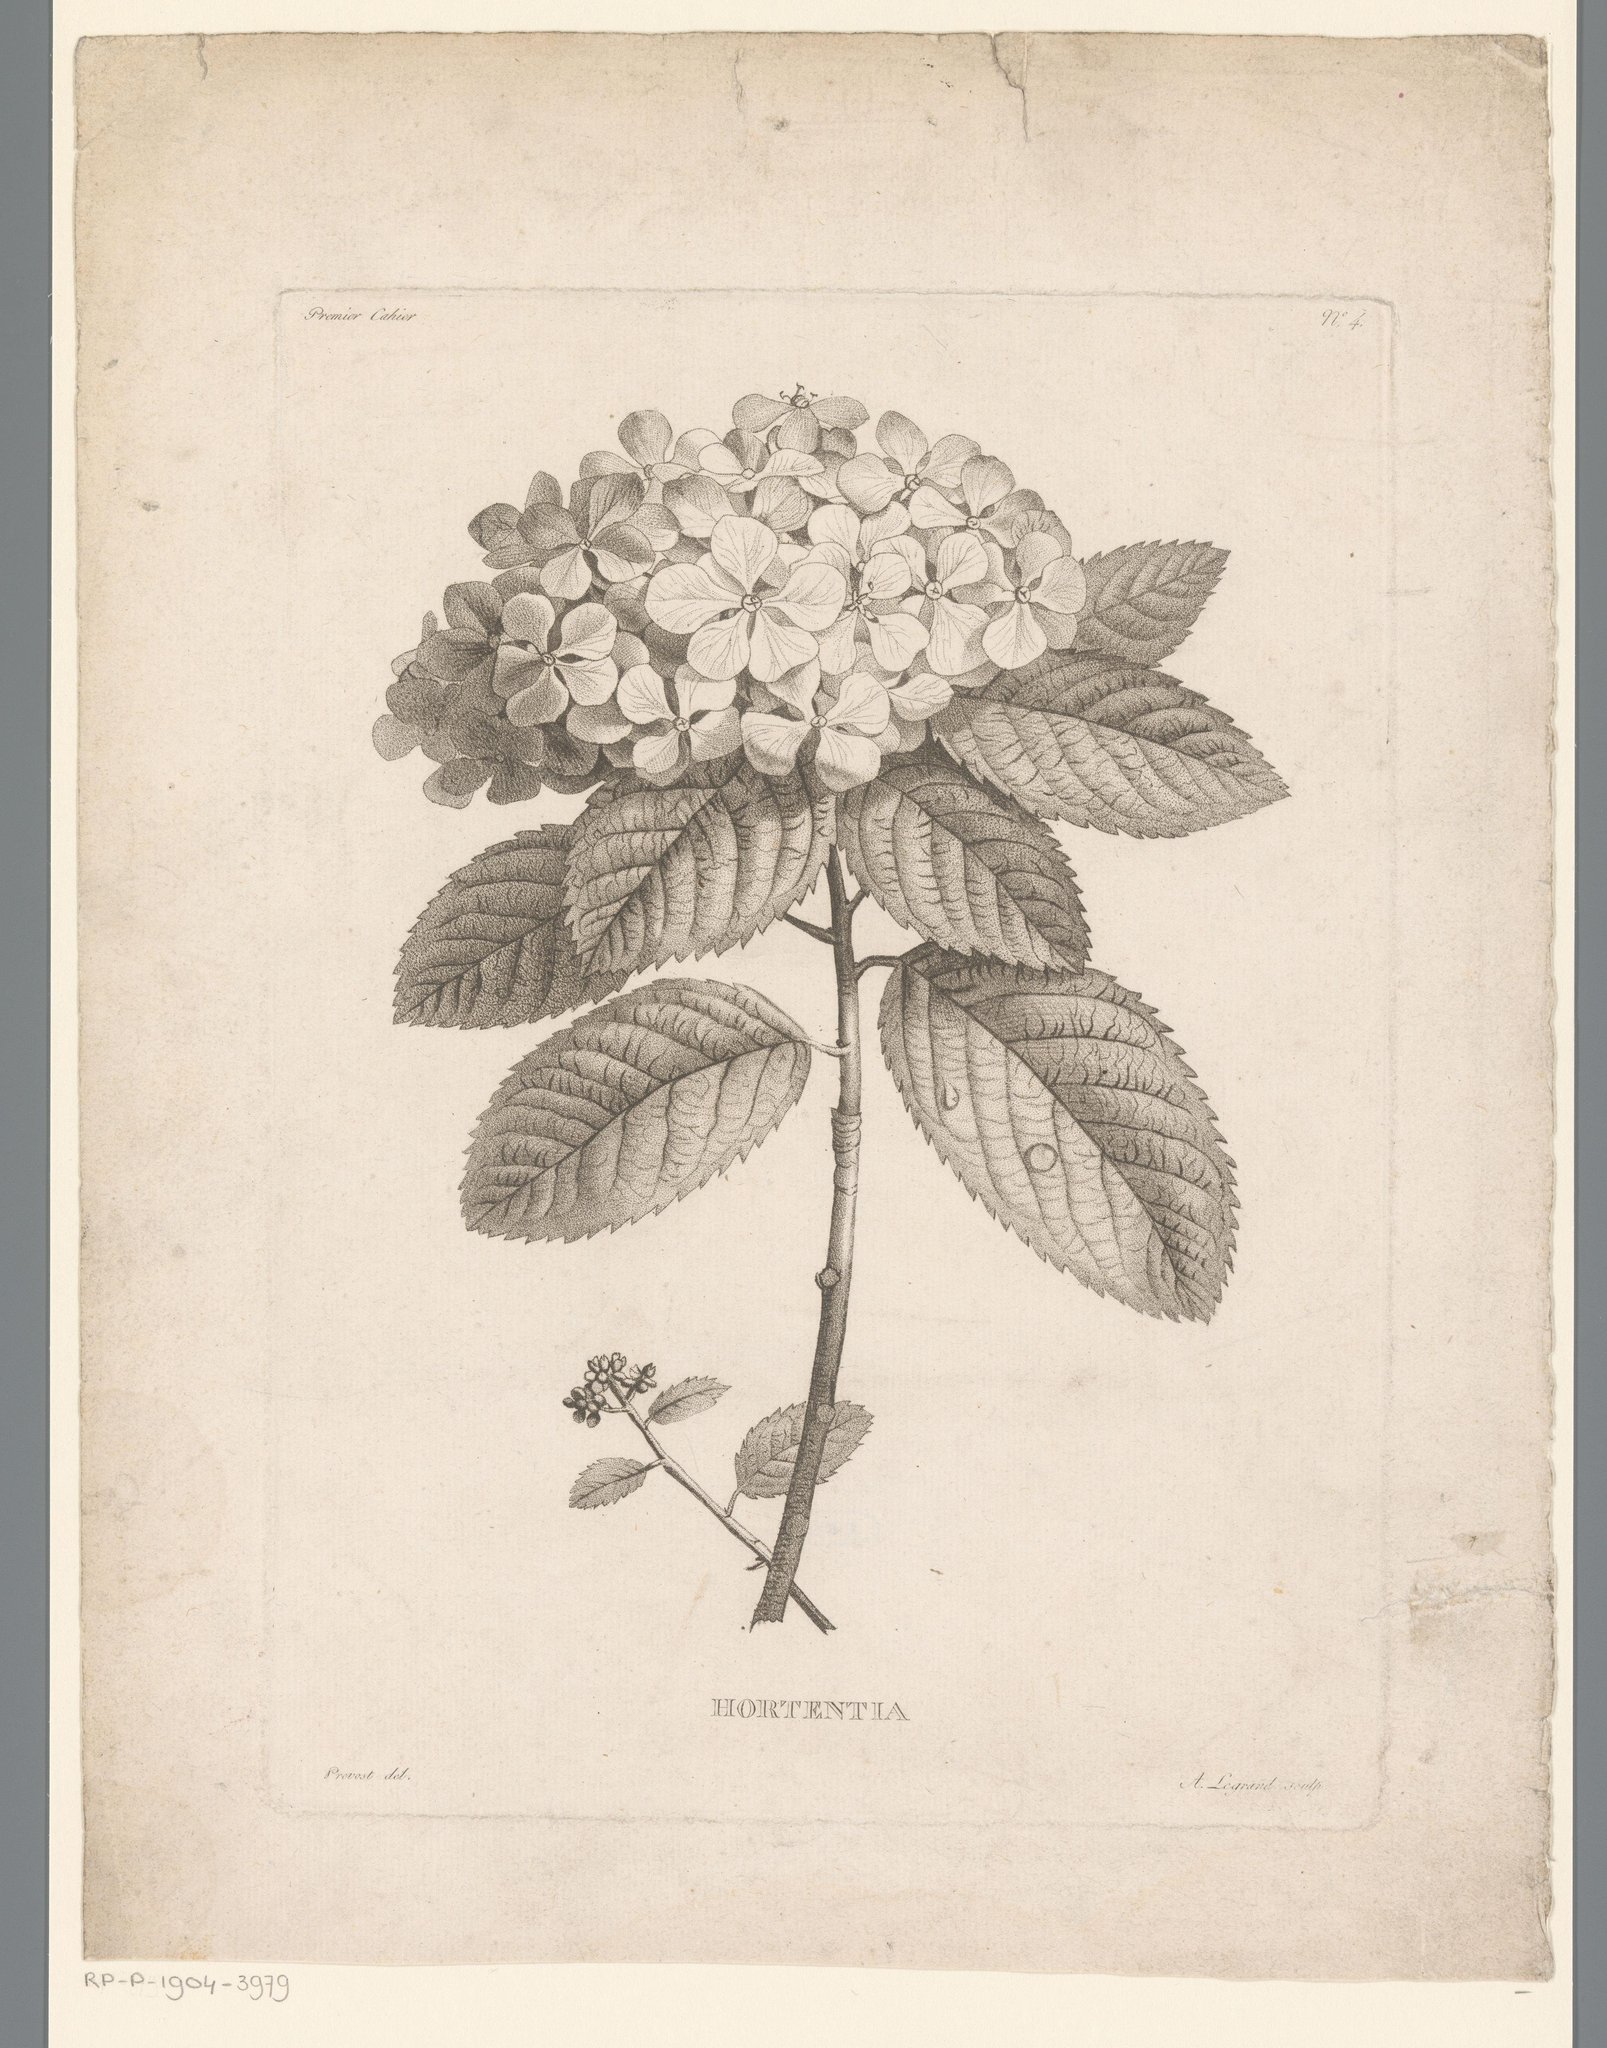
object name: print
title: Premier Cahier de Fleurs et de Fruits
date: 1775-1805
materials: paper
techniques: engraving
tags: flowers: hydrangea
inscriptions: collector's mark: Lugt 2228